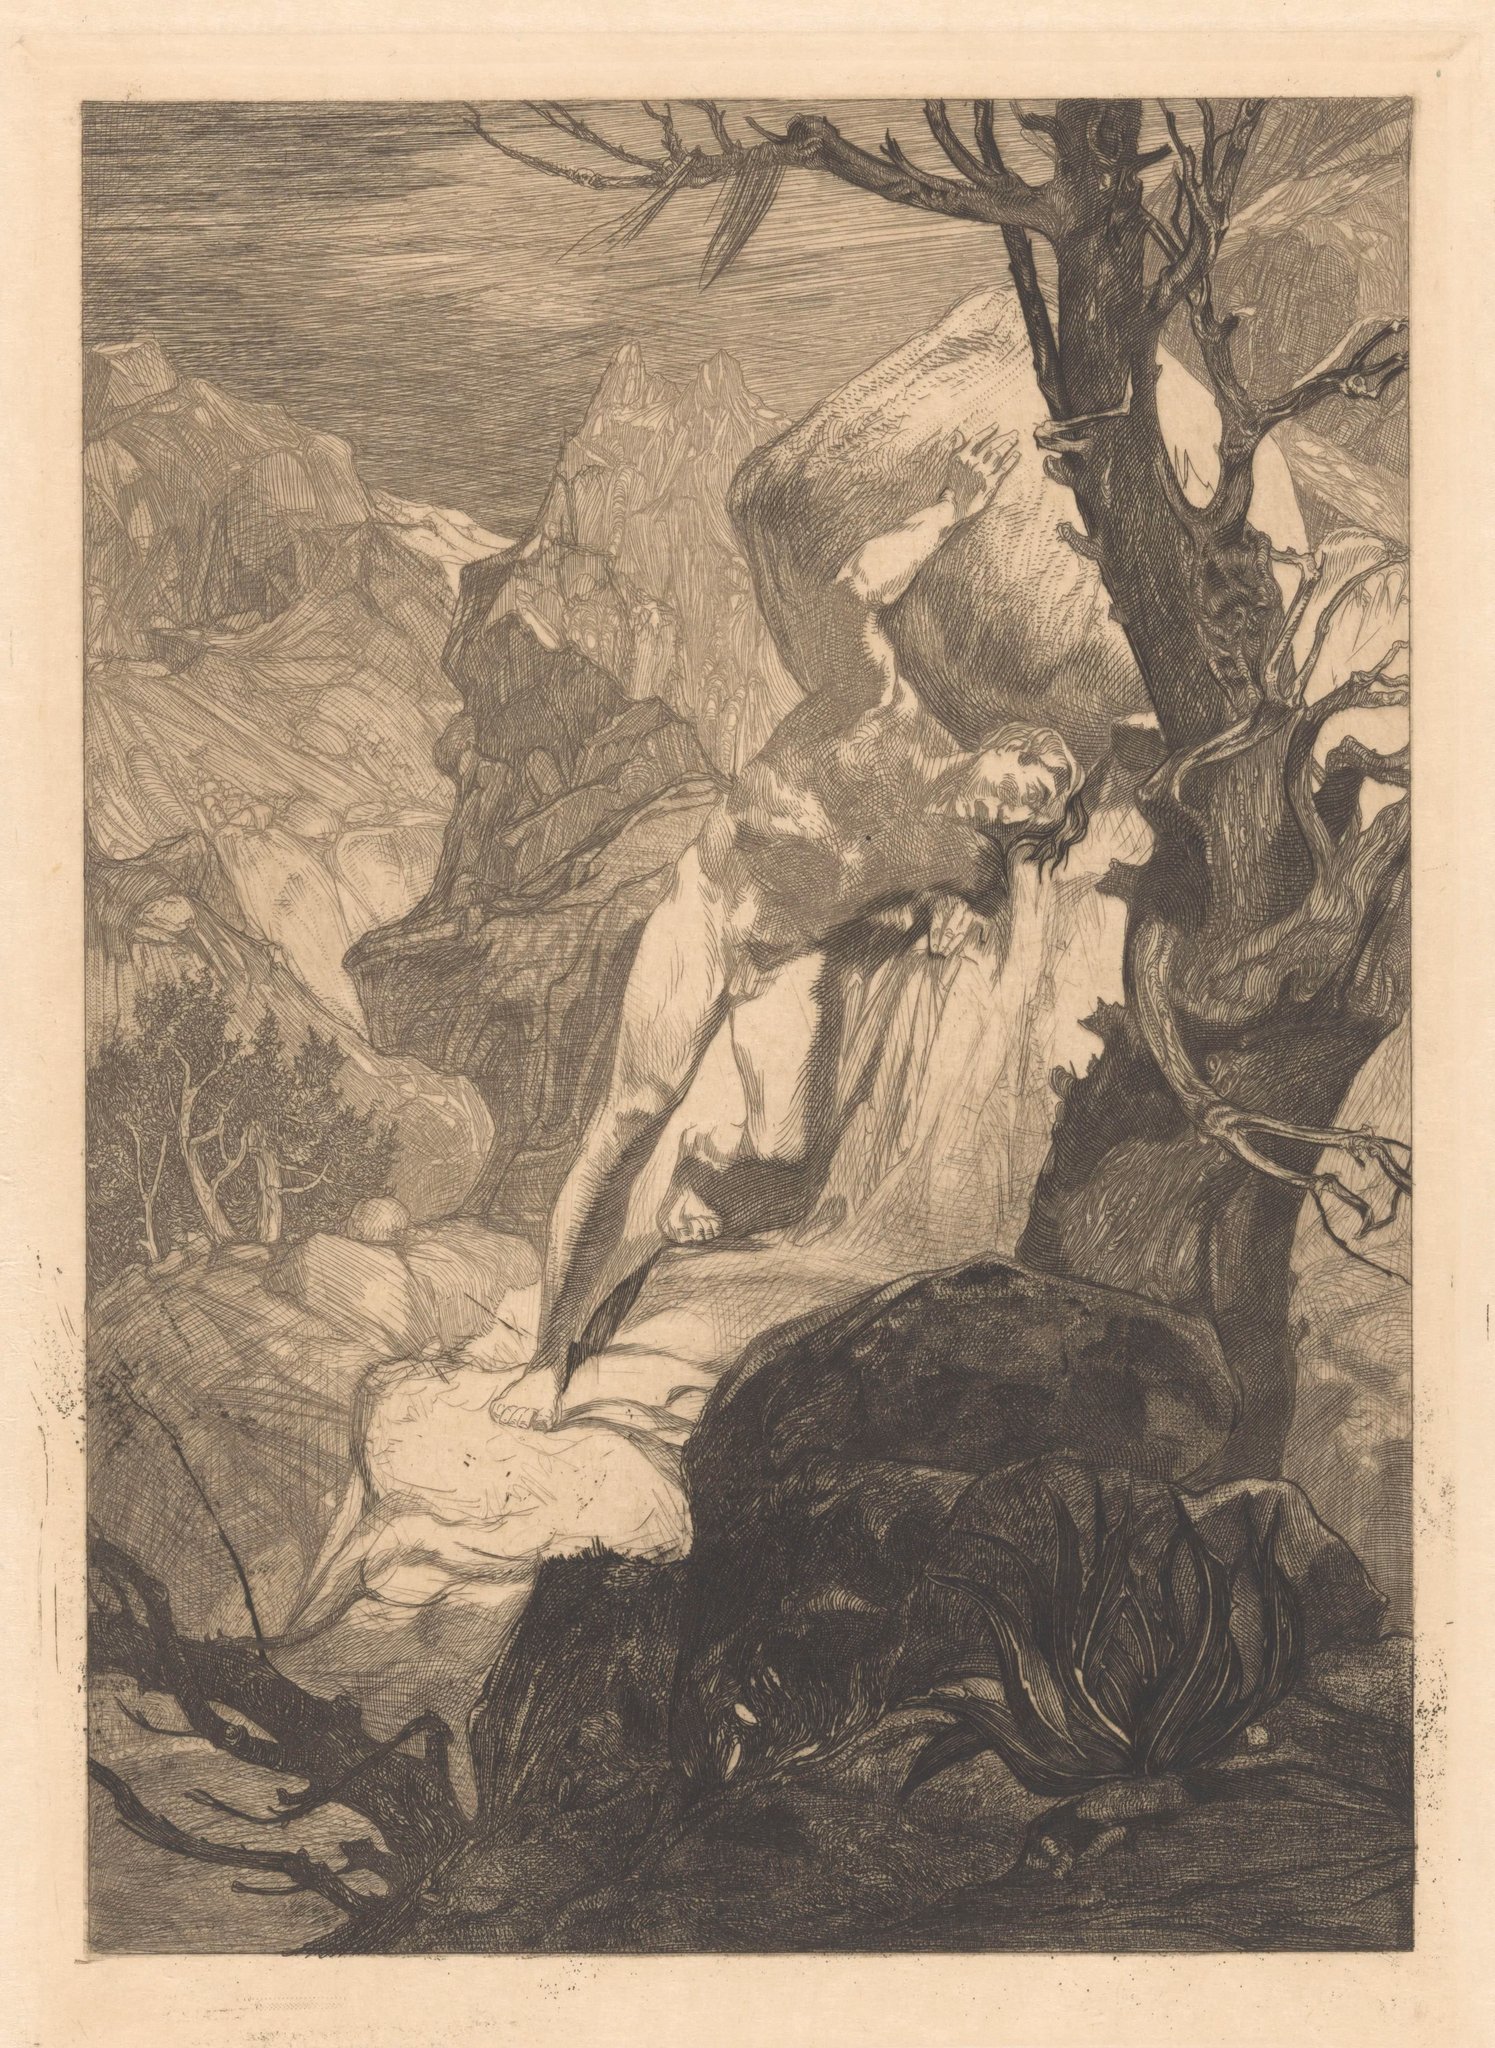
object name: print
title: Gewonde in rotslandschap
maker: johannes josephus aarts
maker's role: draughtsman, print maker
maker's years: 1871-1934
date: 1881-1934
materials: paper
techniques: drypoint, etching, roulette, engraving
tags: the (nude) human figure; 'corpo humano' (ripa), pain, rocks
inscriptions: collector's mark: Lugt 2760, collector's mark: Lugt 2228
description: Een naakte man steunt met open mond tegen een rots in een bergachtig landschap. Op de voorgrond een boom met kale takken.